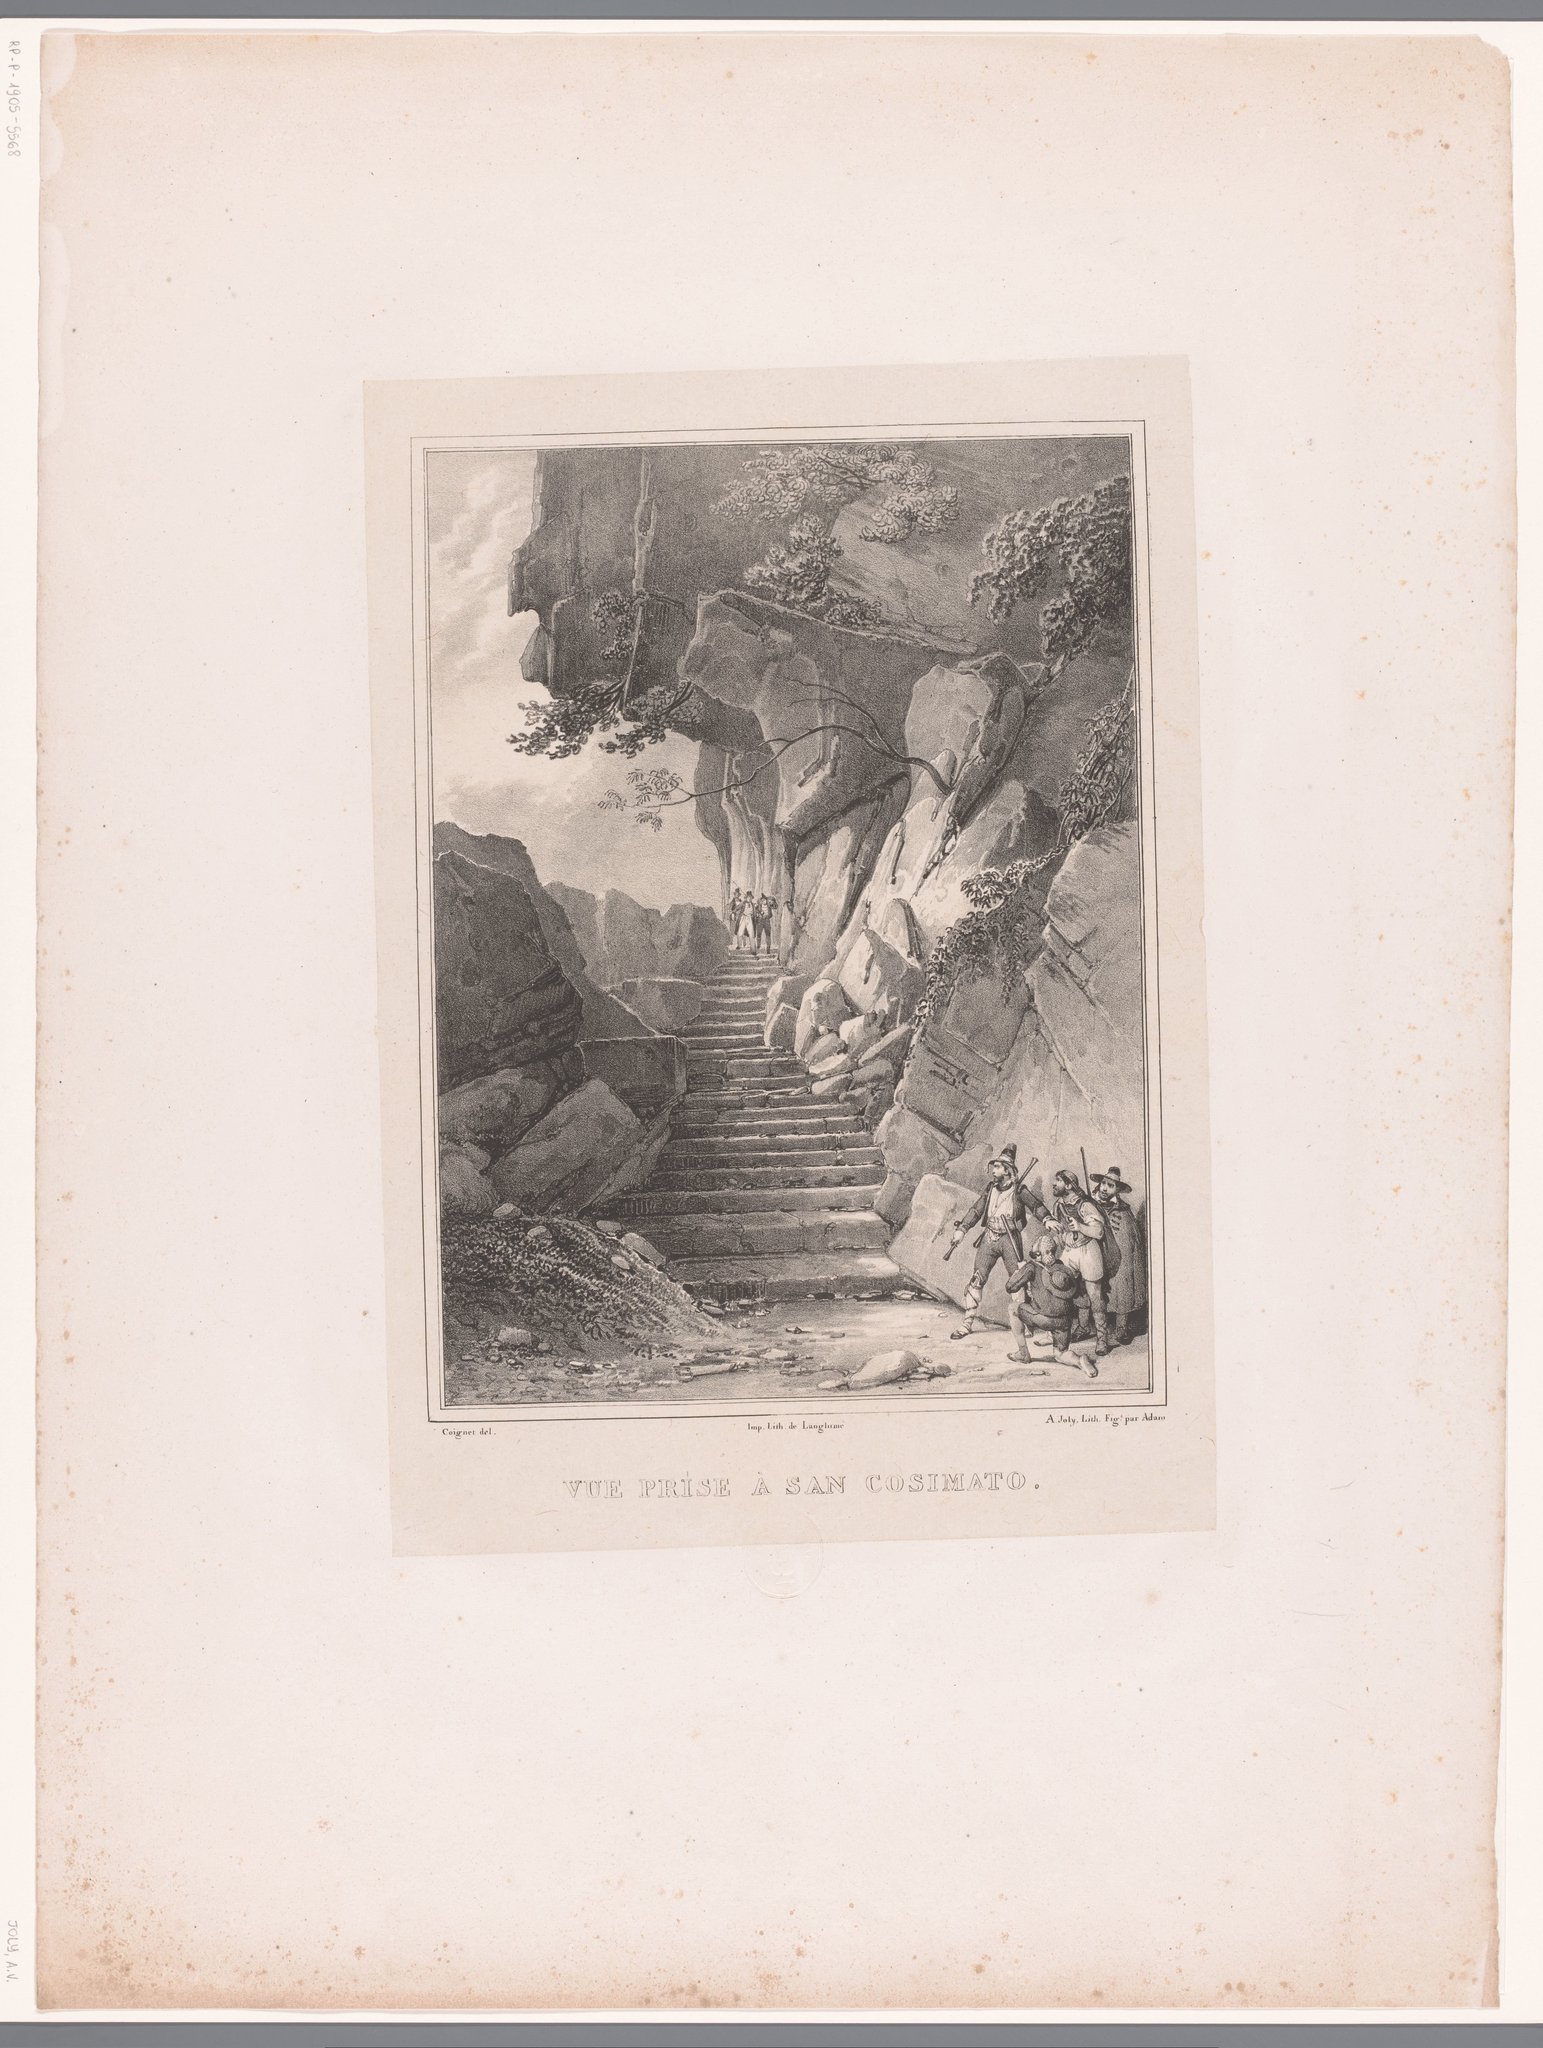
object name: print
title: Gezichten in Italië naar tekeningen van Jules Coignet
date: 1824-1826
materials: paper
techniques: lithograph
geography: paris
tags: traveller(s) attacked by robber(s), robber, surprise attack (from ambush)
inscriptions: check stamp: Lugt 3431, collector's mark: Lugt 2228a